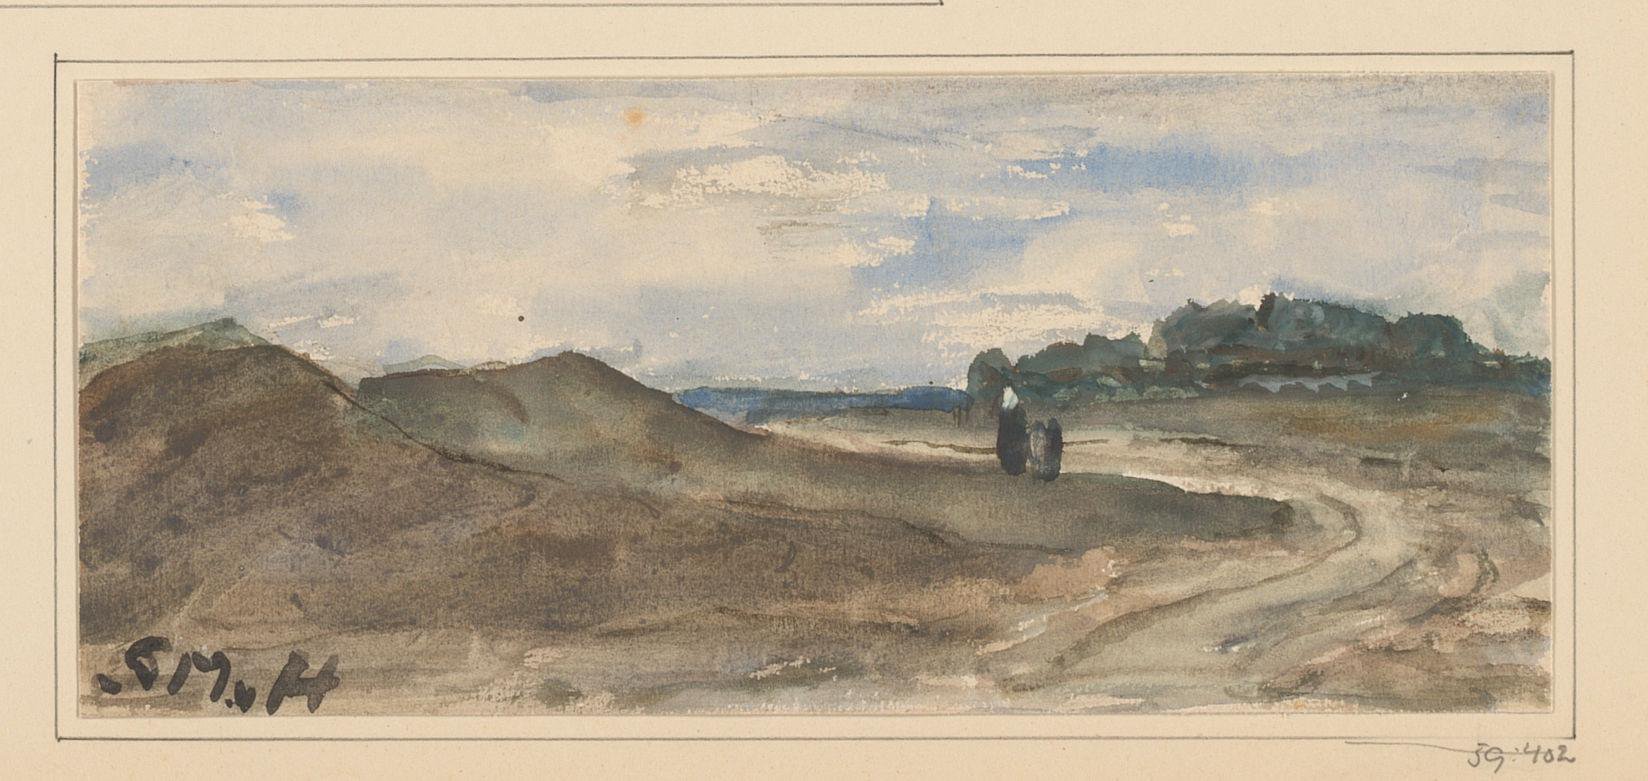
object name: drawing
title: Landschap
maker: sientje mesdag-van houten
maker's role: draughtsman, painter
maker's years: 1834-1909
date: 1856-1909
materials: paper, watercolor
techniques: brush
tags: landscapes in the temperate zone